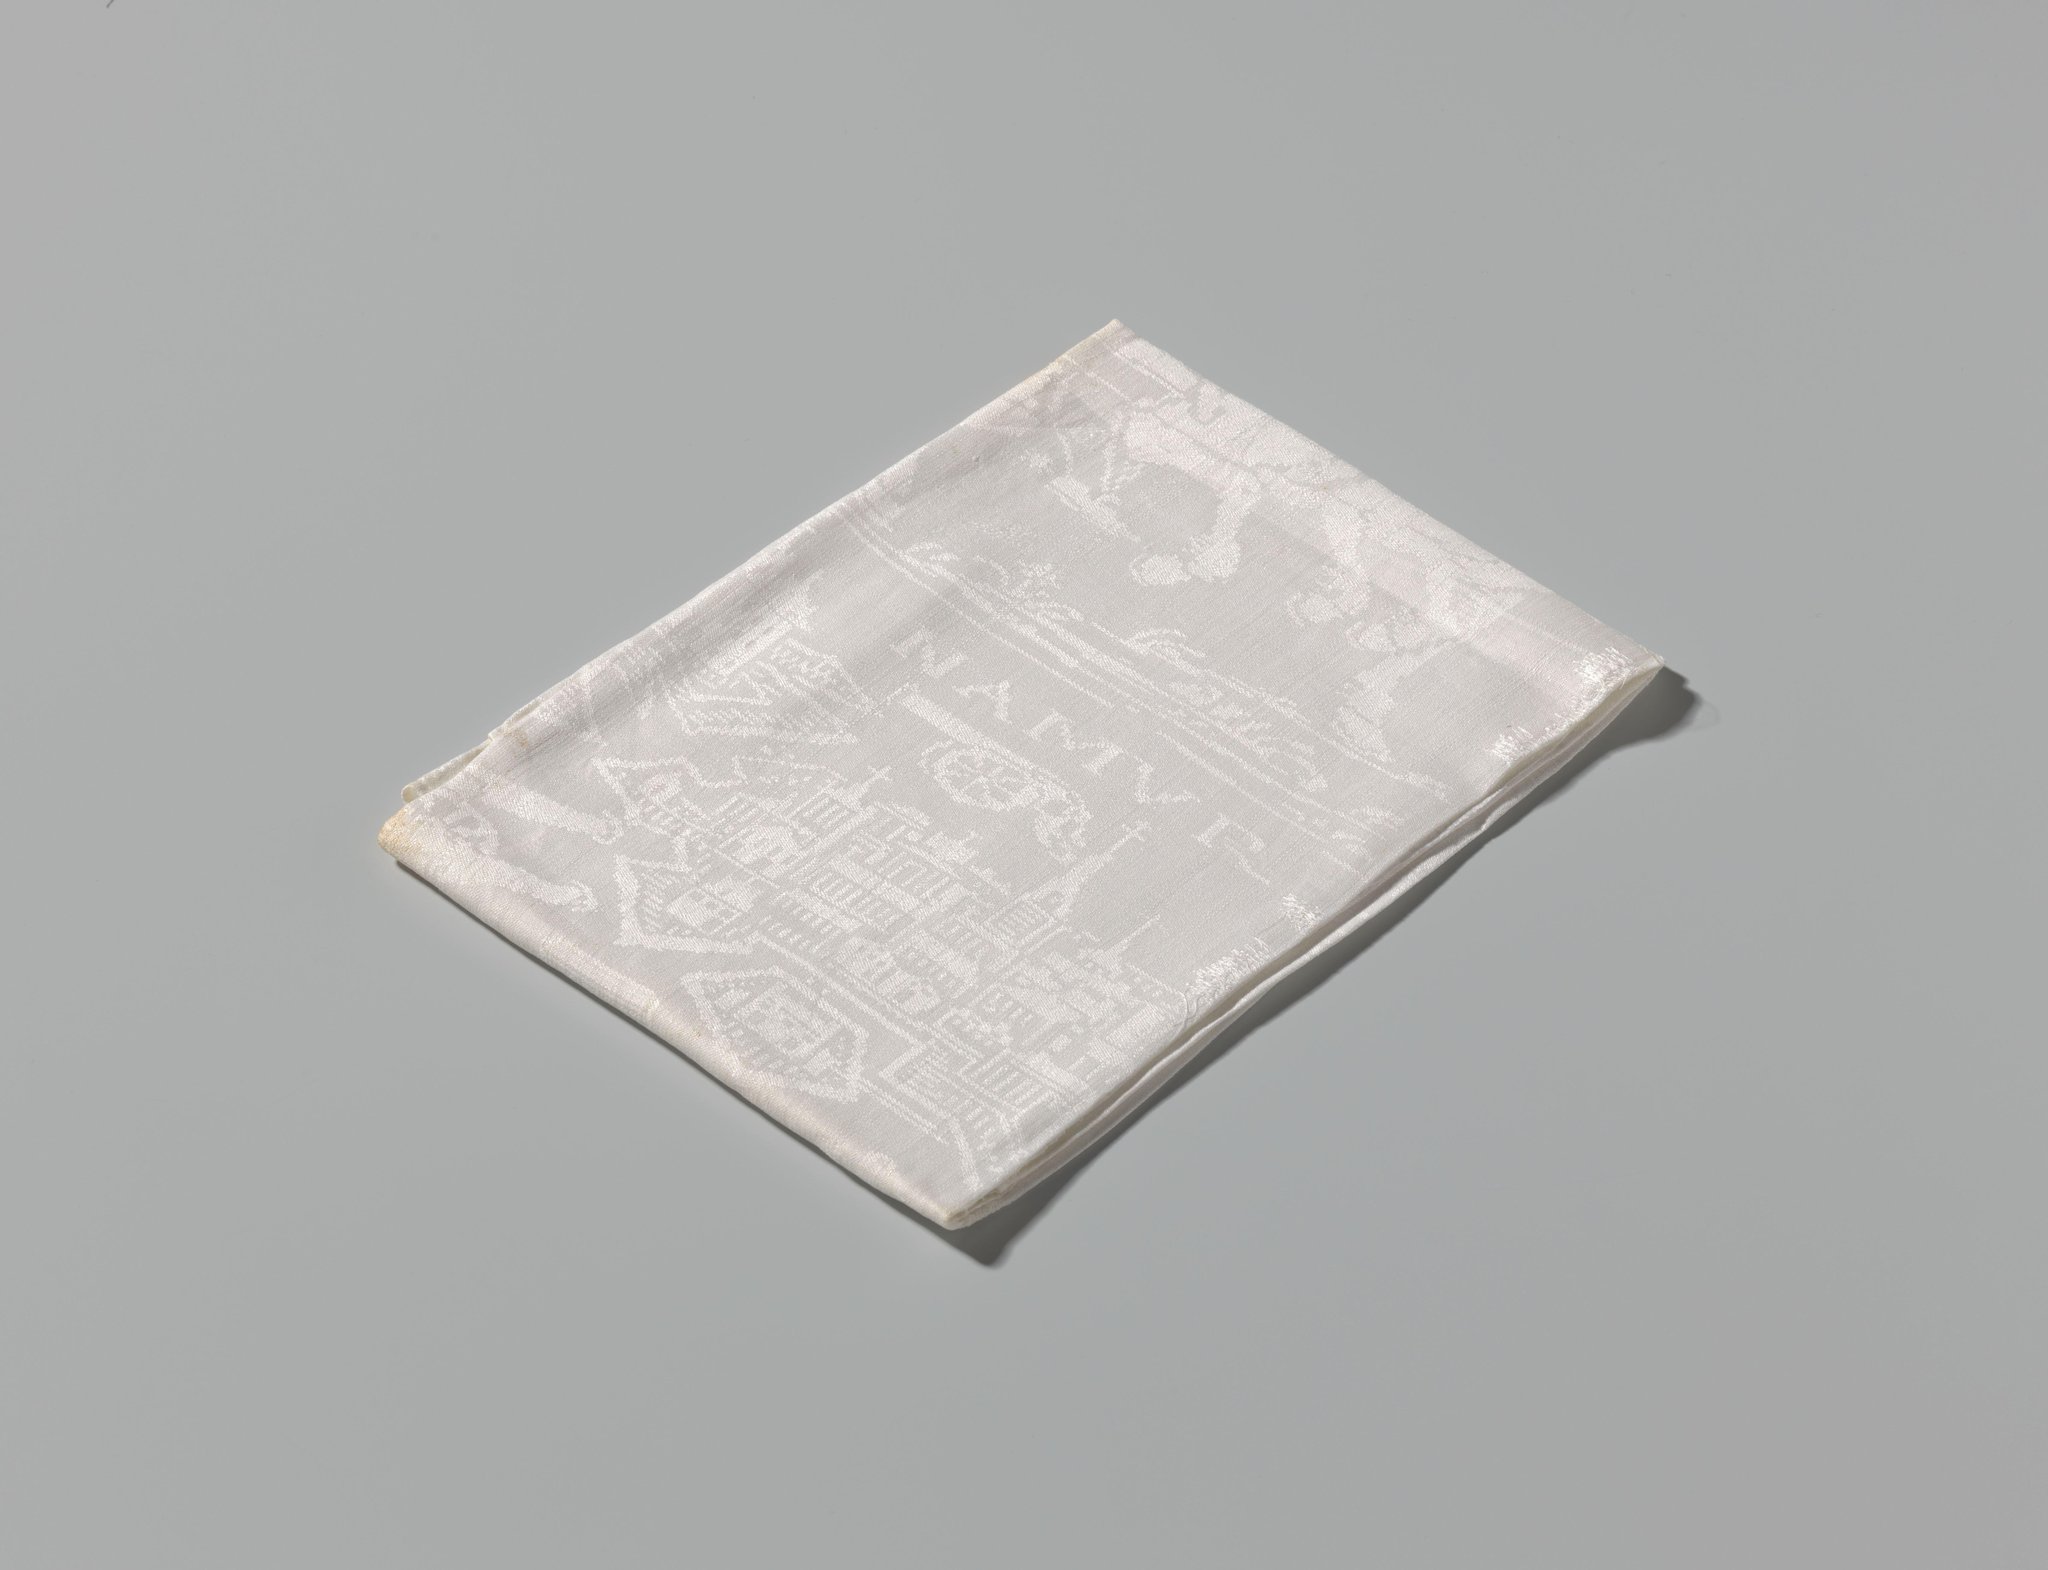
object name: napkin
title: Servet van wit linnendamast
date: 1695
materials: linen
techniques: damask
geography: flanders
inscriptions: label: ‘K.T.’, mark: ‘ICDVL 12’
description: Wit linnen damasten servet met de verovering van Namen en de inweving "NAMVR", gemerkt ICVDL 12.